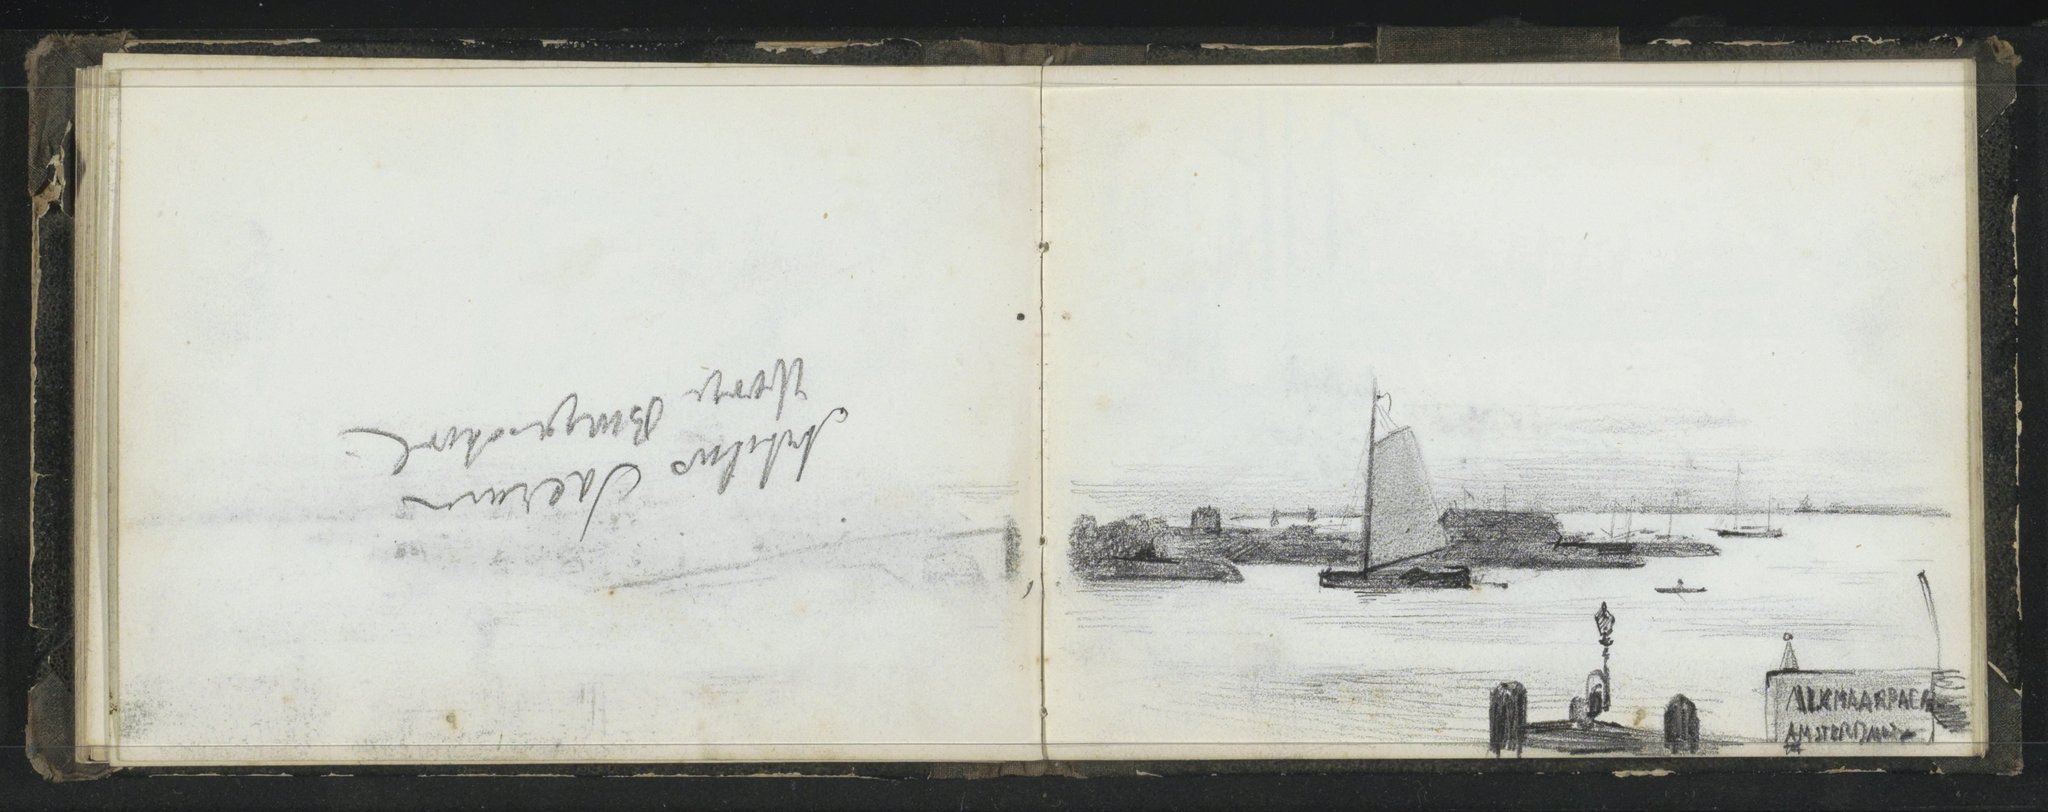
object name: sketchbook leaf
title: Haven met zeilboten en een steiger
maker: theo hanrath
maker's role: draughtsman, painter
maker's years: 1853-1883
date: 1879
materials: paper, pencil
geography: amsterdam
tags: harbour, sailing-ship, sailing-boat, amsterdam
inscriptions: annotation: ‘ALKMAARPA[...]/ AMSTERDAM/ Artilus [...]aeru[...]/ [...] Burgerschool’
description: Blad 18 verso en 19 recto uit een schetsboek met 27 bladen.